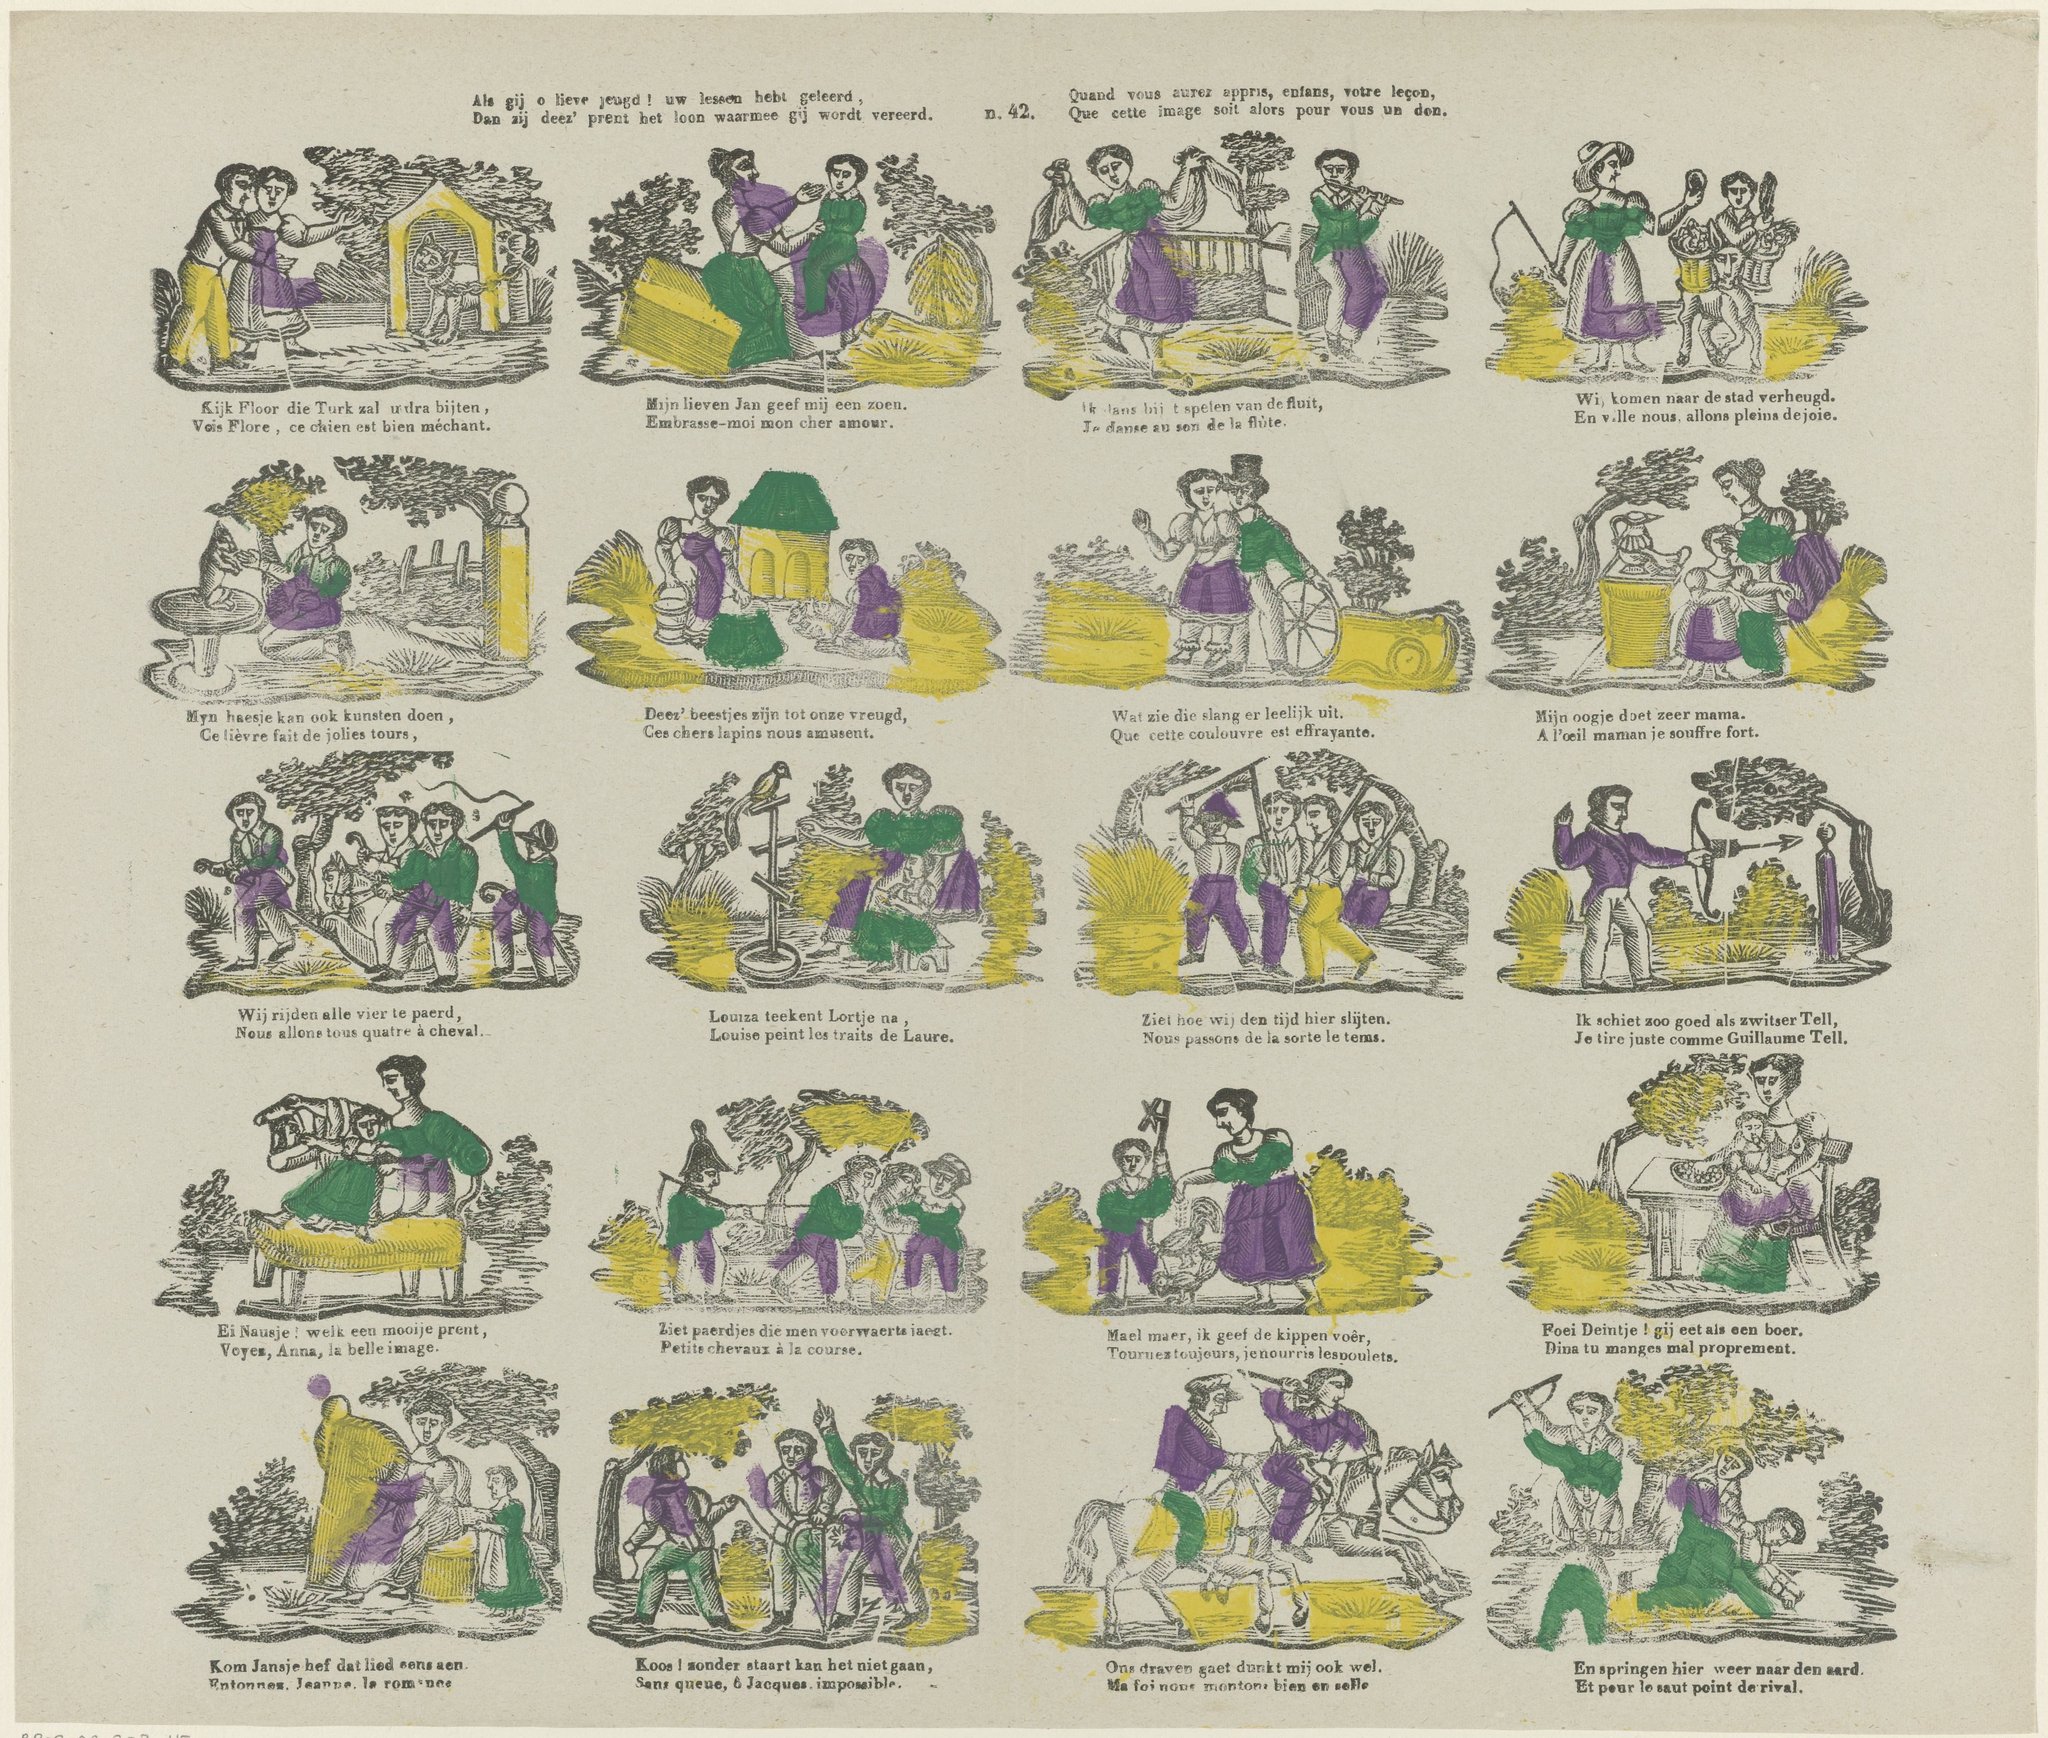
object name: print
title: Als gij o lieve jeugd! uw lessen hebt geleerd, / Dan zij deez' prent het loon waarmee gij wordt vereerd / Quand vous aurez appris, enfans, votre leçon, / que zette image soit alors pour vous un don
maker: Anonymous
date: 1856-1900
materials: paper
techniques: colour, letterpress printing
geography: turnhout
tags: children's games and plays, child playing with animals, (flying a) kite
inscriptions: collector's mark: Lugt 2760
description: Blad met 20 voorstellingen van kinderspelen en bezigheden, zoals dansen, harp spelen en vliegeren. Onder elke voorstelling een onderschrift in het Nederlands en in het Frans. Genummerd midden boven: n. 42.